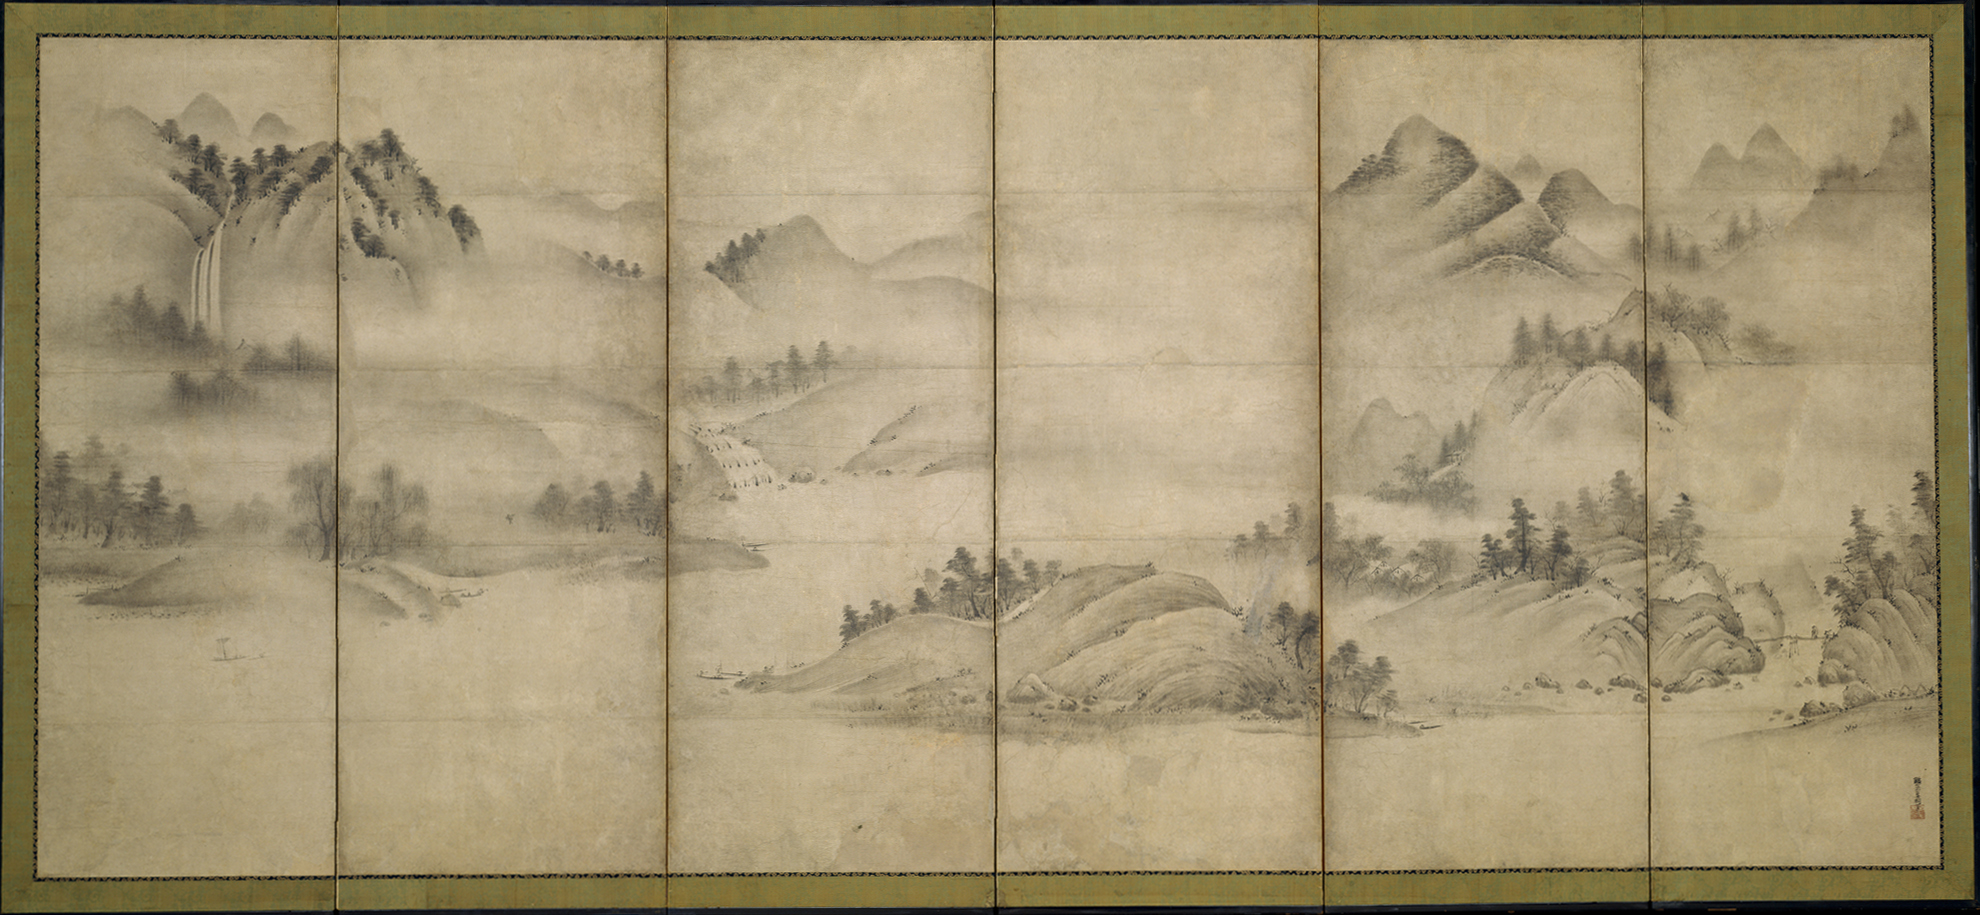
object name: screen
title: Landscape of the Four Seasons (Eight Views of the Xiao and Xiang Rivers)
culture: japanese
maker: sōami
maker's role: artist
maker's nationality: japanese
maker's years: 1485-1525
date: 1501-1533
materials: ink, panel, paper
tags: mountains,landscapes